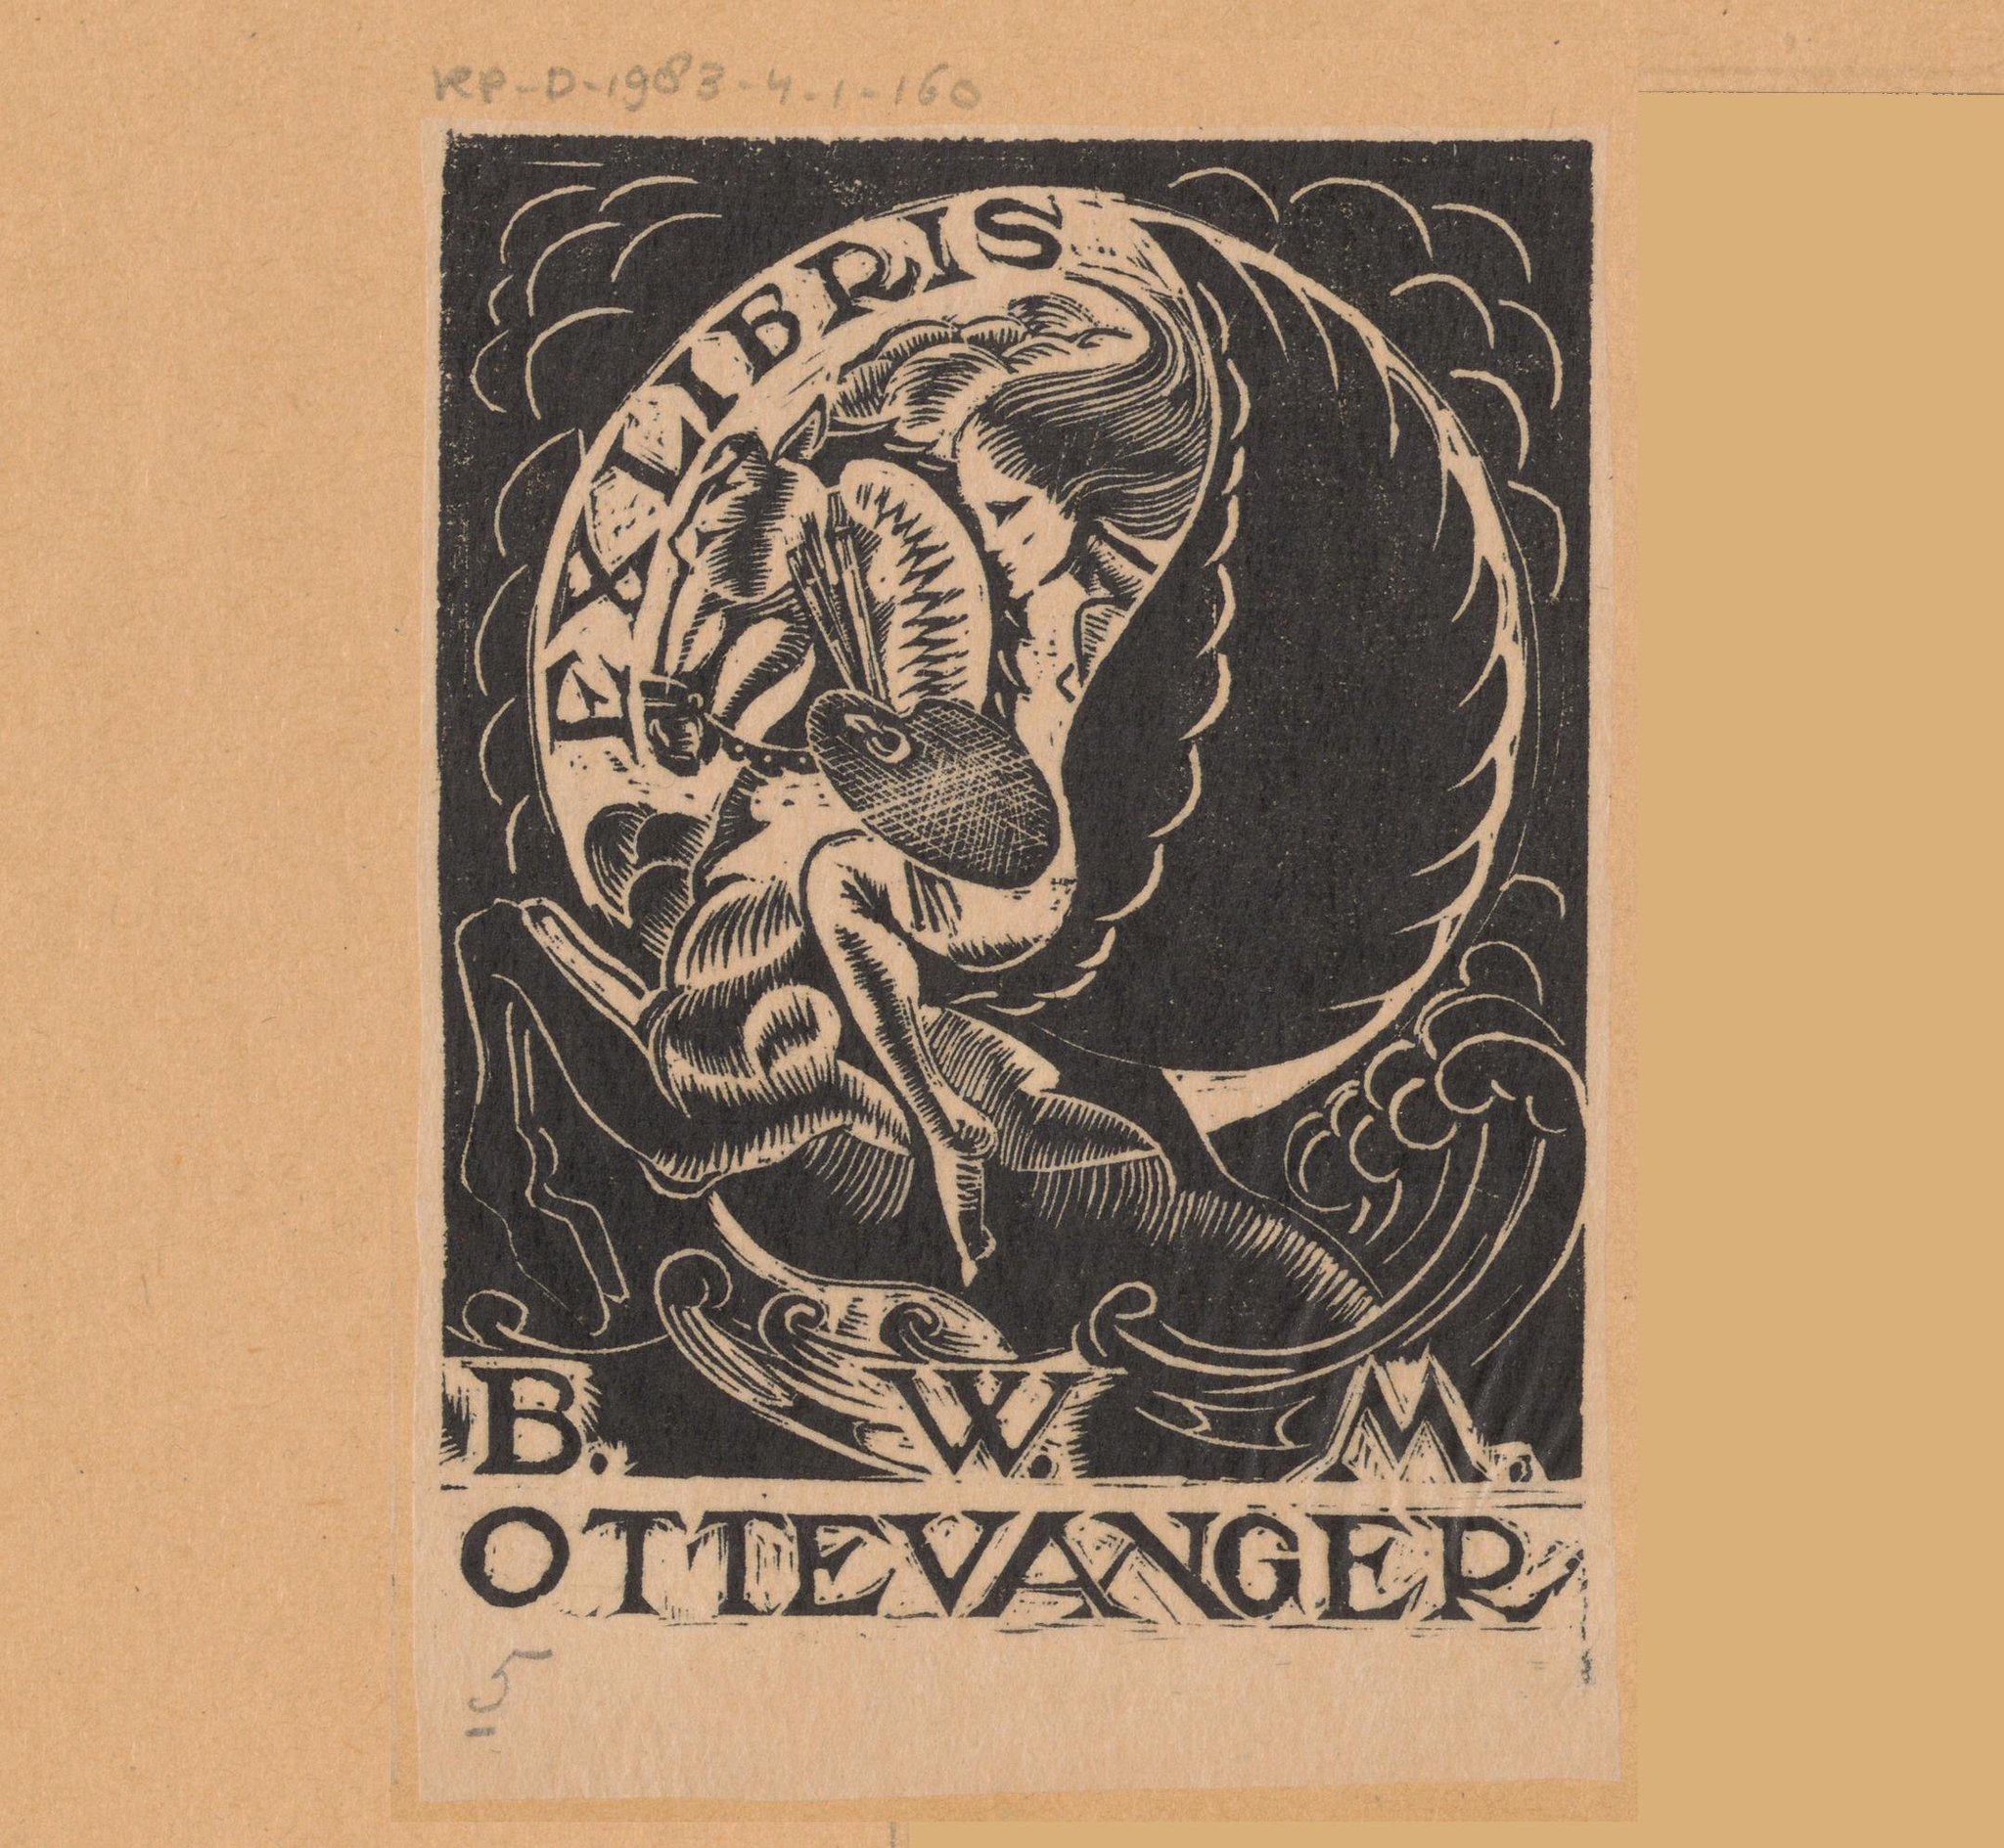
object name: bookplate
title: Ex libris van Bernard Ottevanger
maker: otto verhagen (i)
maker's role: draughtsman, print maker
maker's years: 1885-1951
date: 1947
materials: paper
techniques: woodcut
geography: netherlands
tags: riding a horse, ass, or mule; rider, horseman, pegasus, the winged horse, palette, horse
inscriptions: inscription: ‘5.’